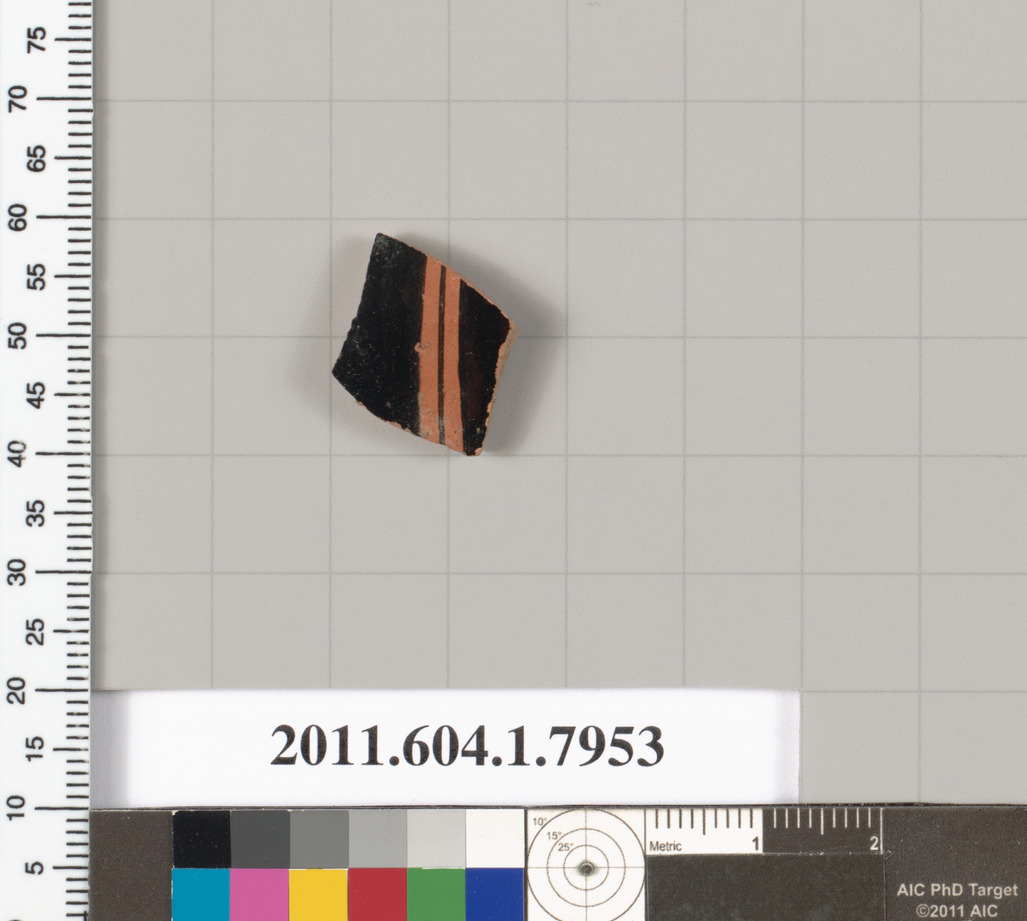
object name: kylix fragment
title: Terracotta fragment of a kylix (drinking cup)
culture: greek, attic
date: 460-450 BCE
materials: terracotta